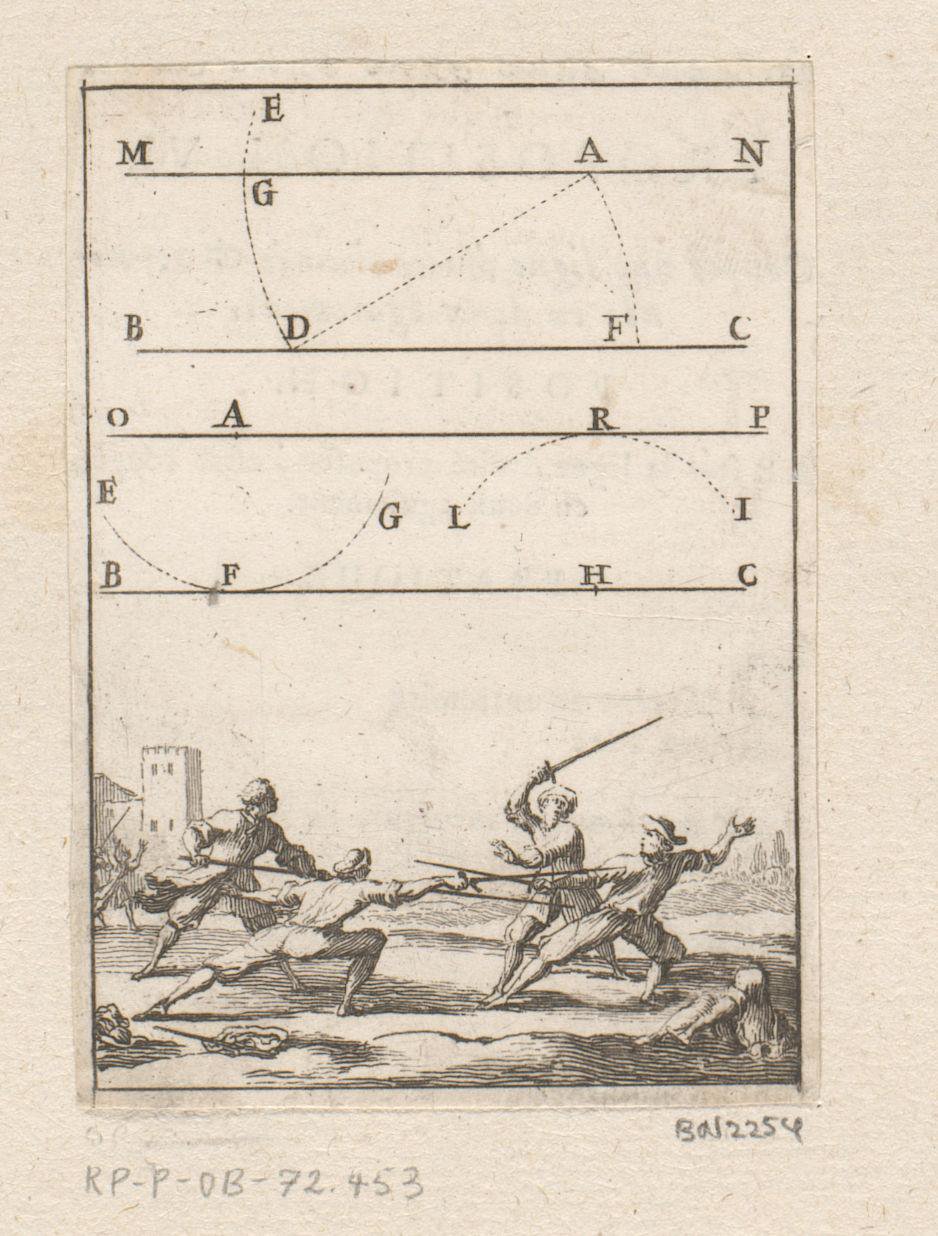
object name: book illustration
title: Parallelle lijnen trekken door een gegeven punt met onderaan schermende mannen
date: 1669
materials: paper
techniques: etching, letterpress printing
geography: france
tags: planimetry, geometry, fencing (sport)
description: Prent uit: Pratique de la géometrie, sur le papier et sur le terrain. Avec un nouvel ordre et une méthode particulière. Parijs: Thomas Jolly, 1669.